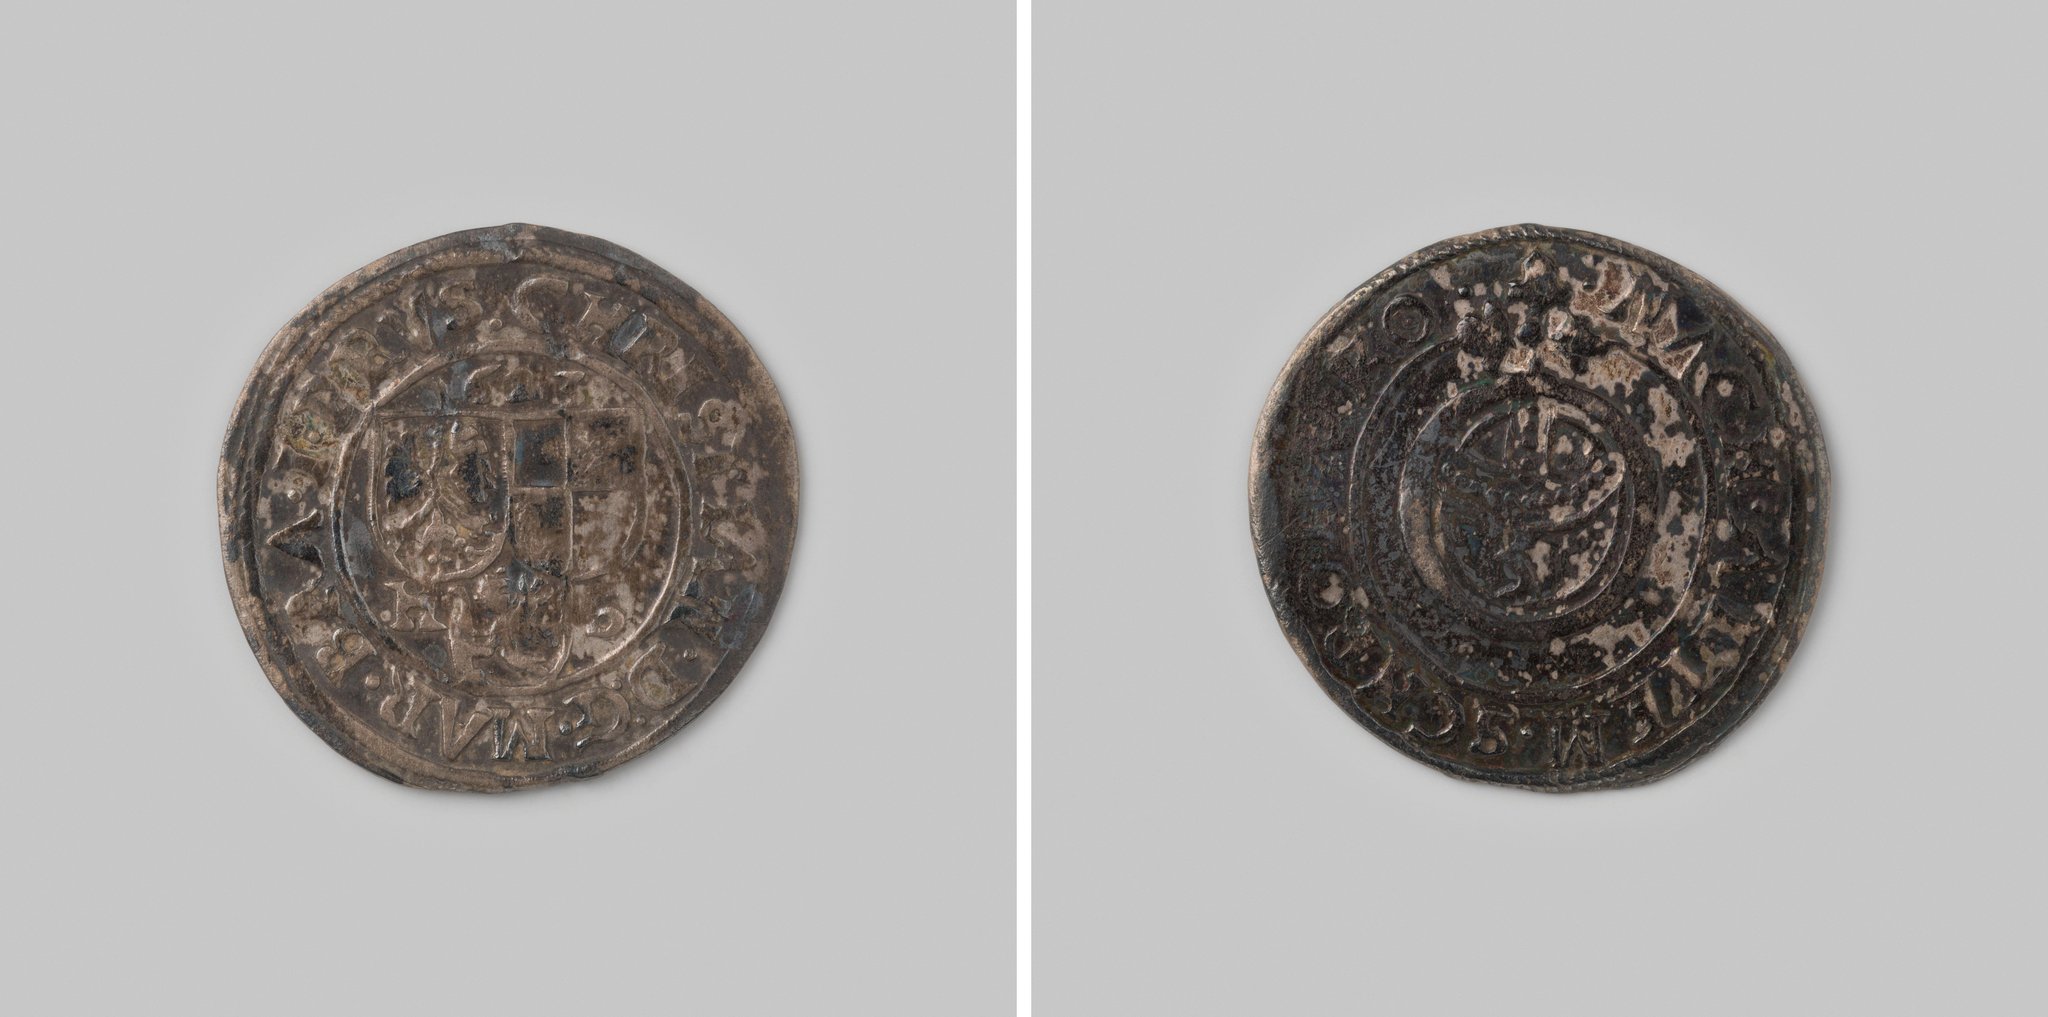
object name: drie kreuzer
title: Brandenburg-Bayreuth, markgraaf Christian, 3 kreuzer, 1623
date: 1623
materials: silver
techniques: striking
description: Zilveren munt. Voorzijde: drie naast en onder elkaar geplaatste wapenschilden, waarboven jaartal. Keerzijde: rijksappel, waarin waarde-aanduiding 3.